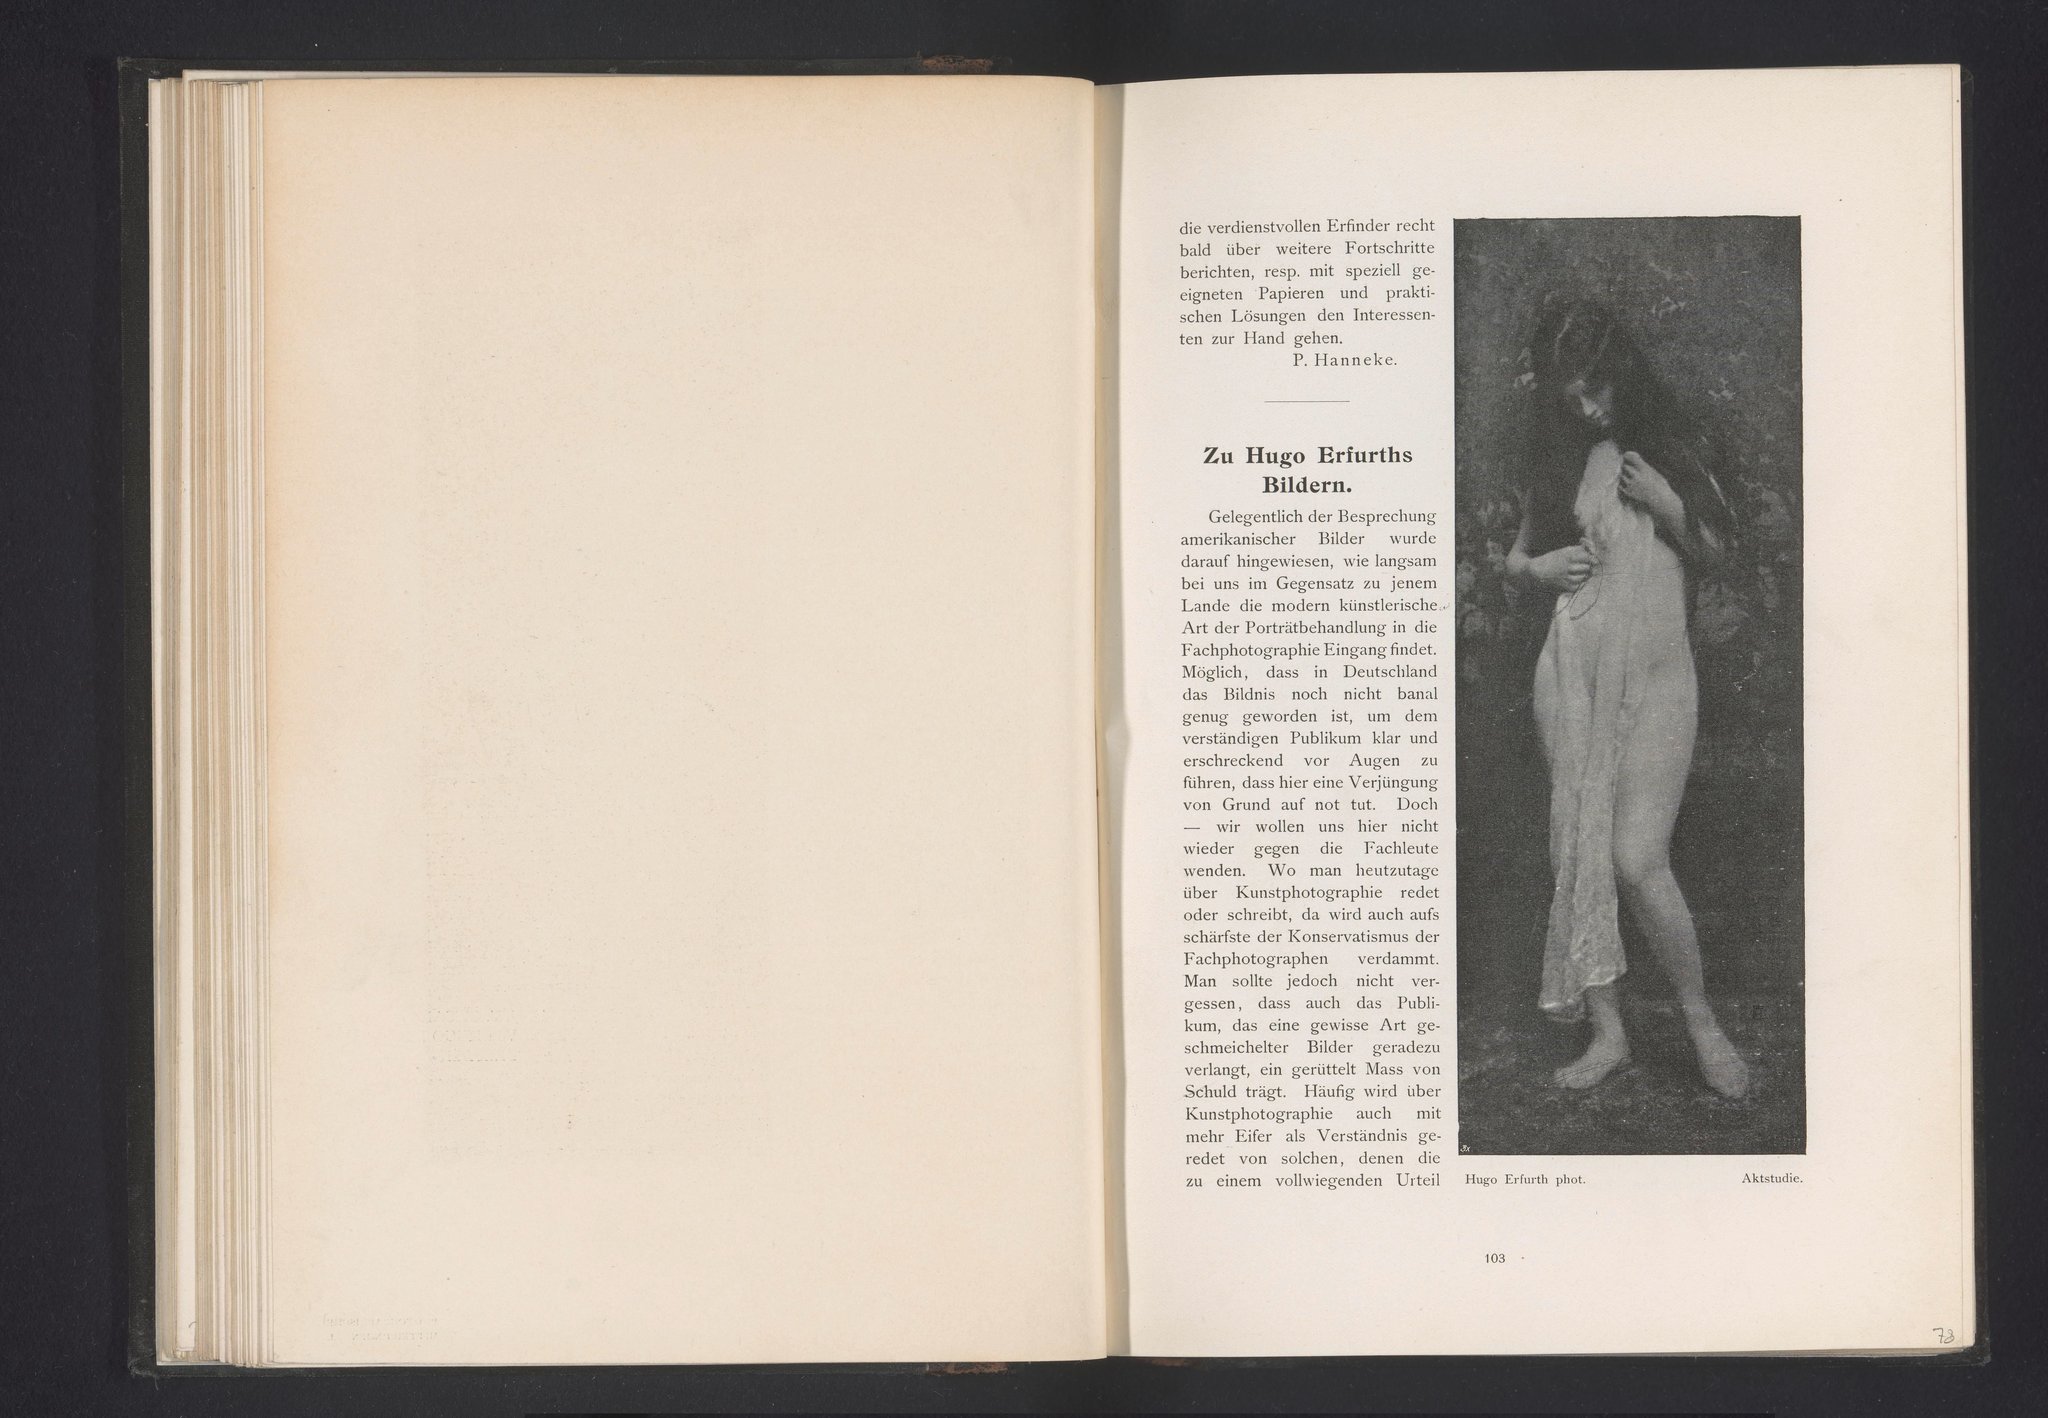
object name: page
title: Naaktstudie van een half naakte vrouw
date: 1898-1903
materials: paper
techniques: autotype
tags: woman (showing herself) undressed, quasi-nude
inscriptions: monogram: ‘BX’